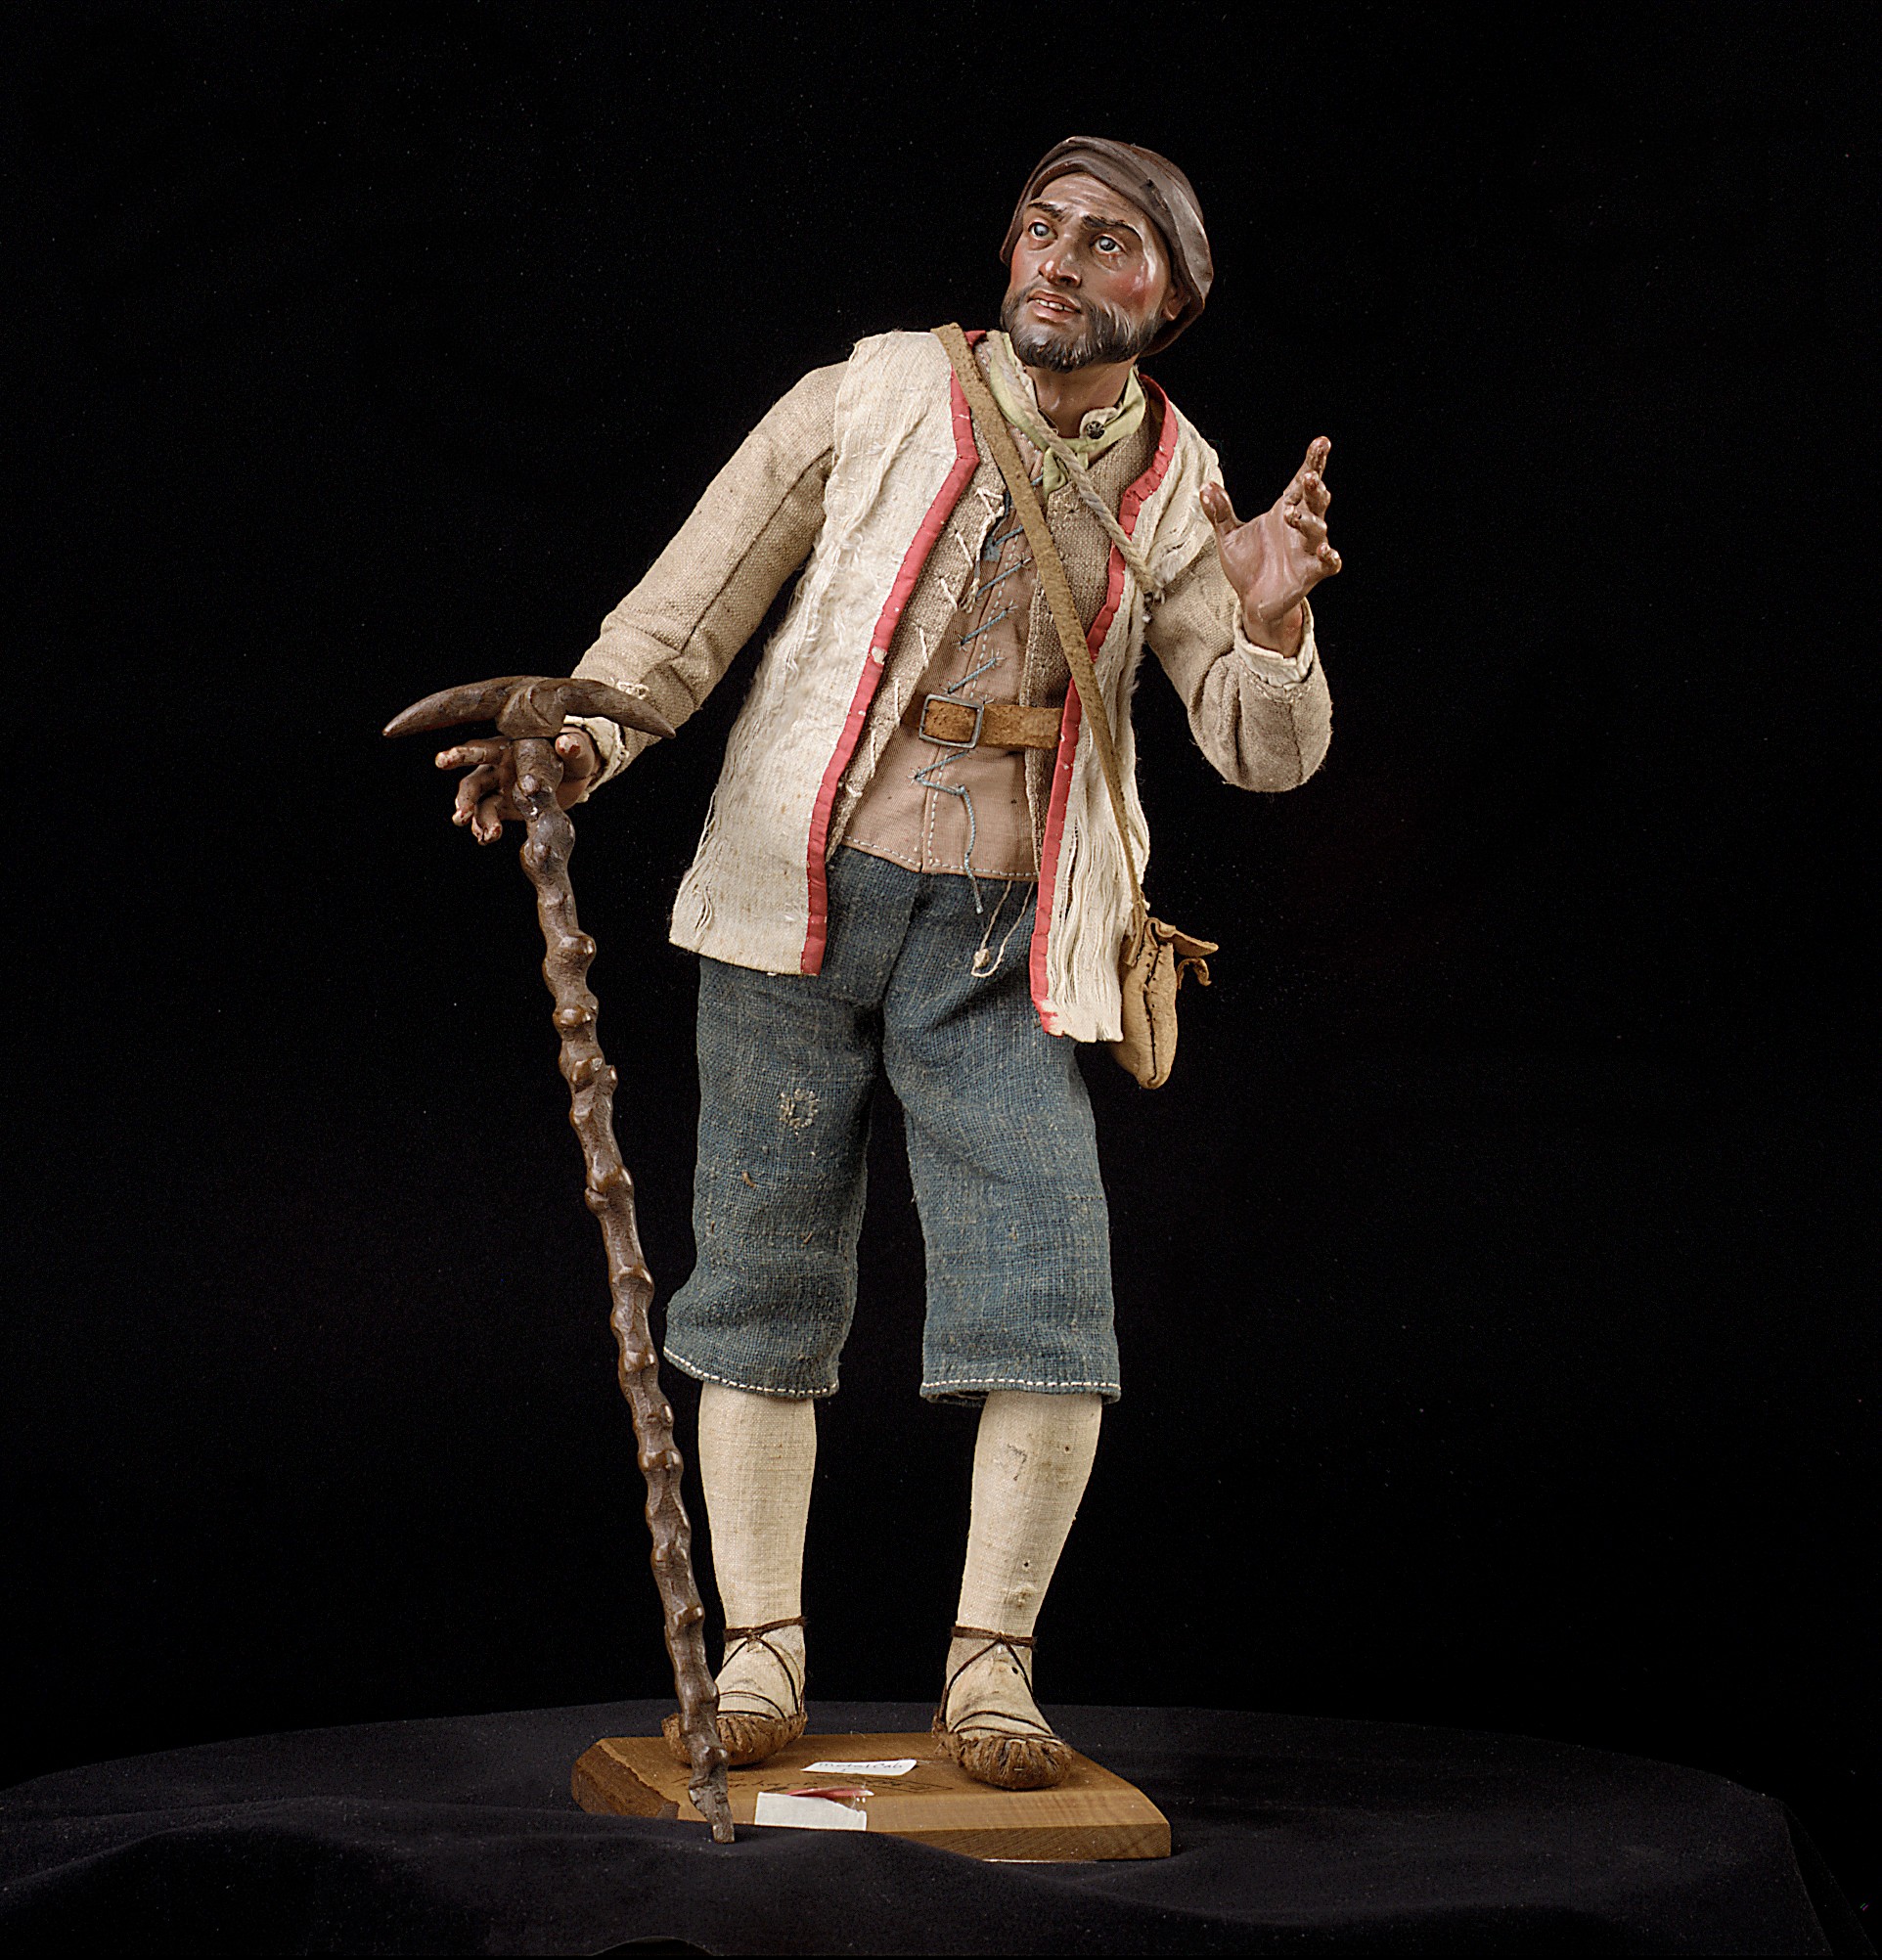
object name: crèche figure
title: Man with staff and brace of birds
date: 1767-1833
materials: textile, leather, metal, fiber, terracotta, wood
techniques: polychrome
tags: men